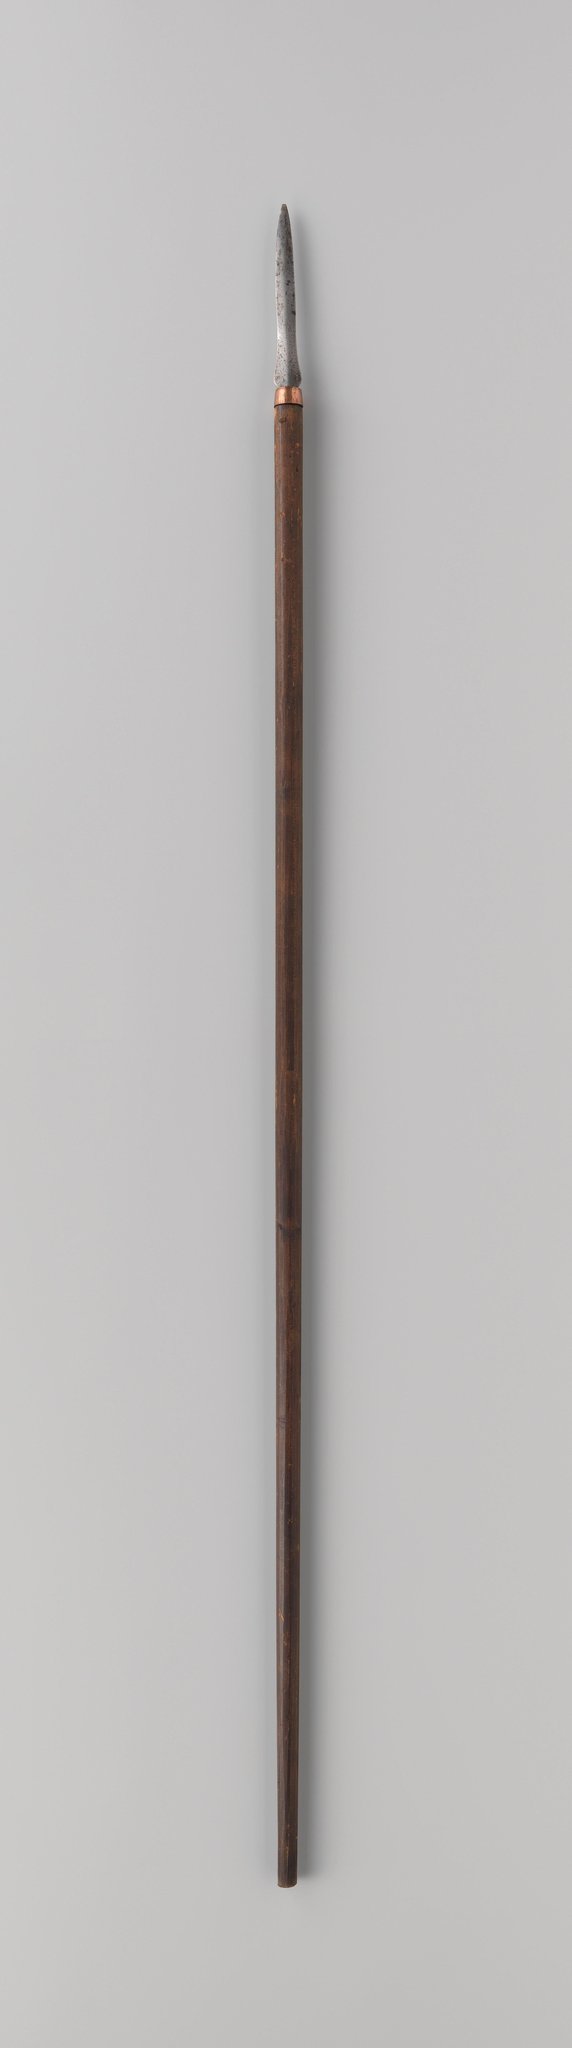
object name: lanspunt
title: Lanspunt met koperen ring en ontbrekend hout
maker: Anonymous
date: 1850-1900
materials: copper, iron, wood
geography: indonesia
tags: lombok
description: Lans met tweesnijdende kling met gebolde middengraat, de kling zit vast met een pin in de schacht. Het uiteinde van de schacht bestaat uit een rood koperen opengewerkte huls. De schacht is van bruin hout waarvan de bovenkant dikker is dan de onderkant. Aan de bovenzijde van de schacht staat het nummer 10567. De schede is van hout en heeft een breed insteekpunt maar loopt uit in een punt. Om de rand een rood koperen opengewerkte huls. Op de schede staat het nummer 725 0? 6644 10.